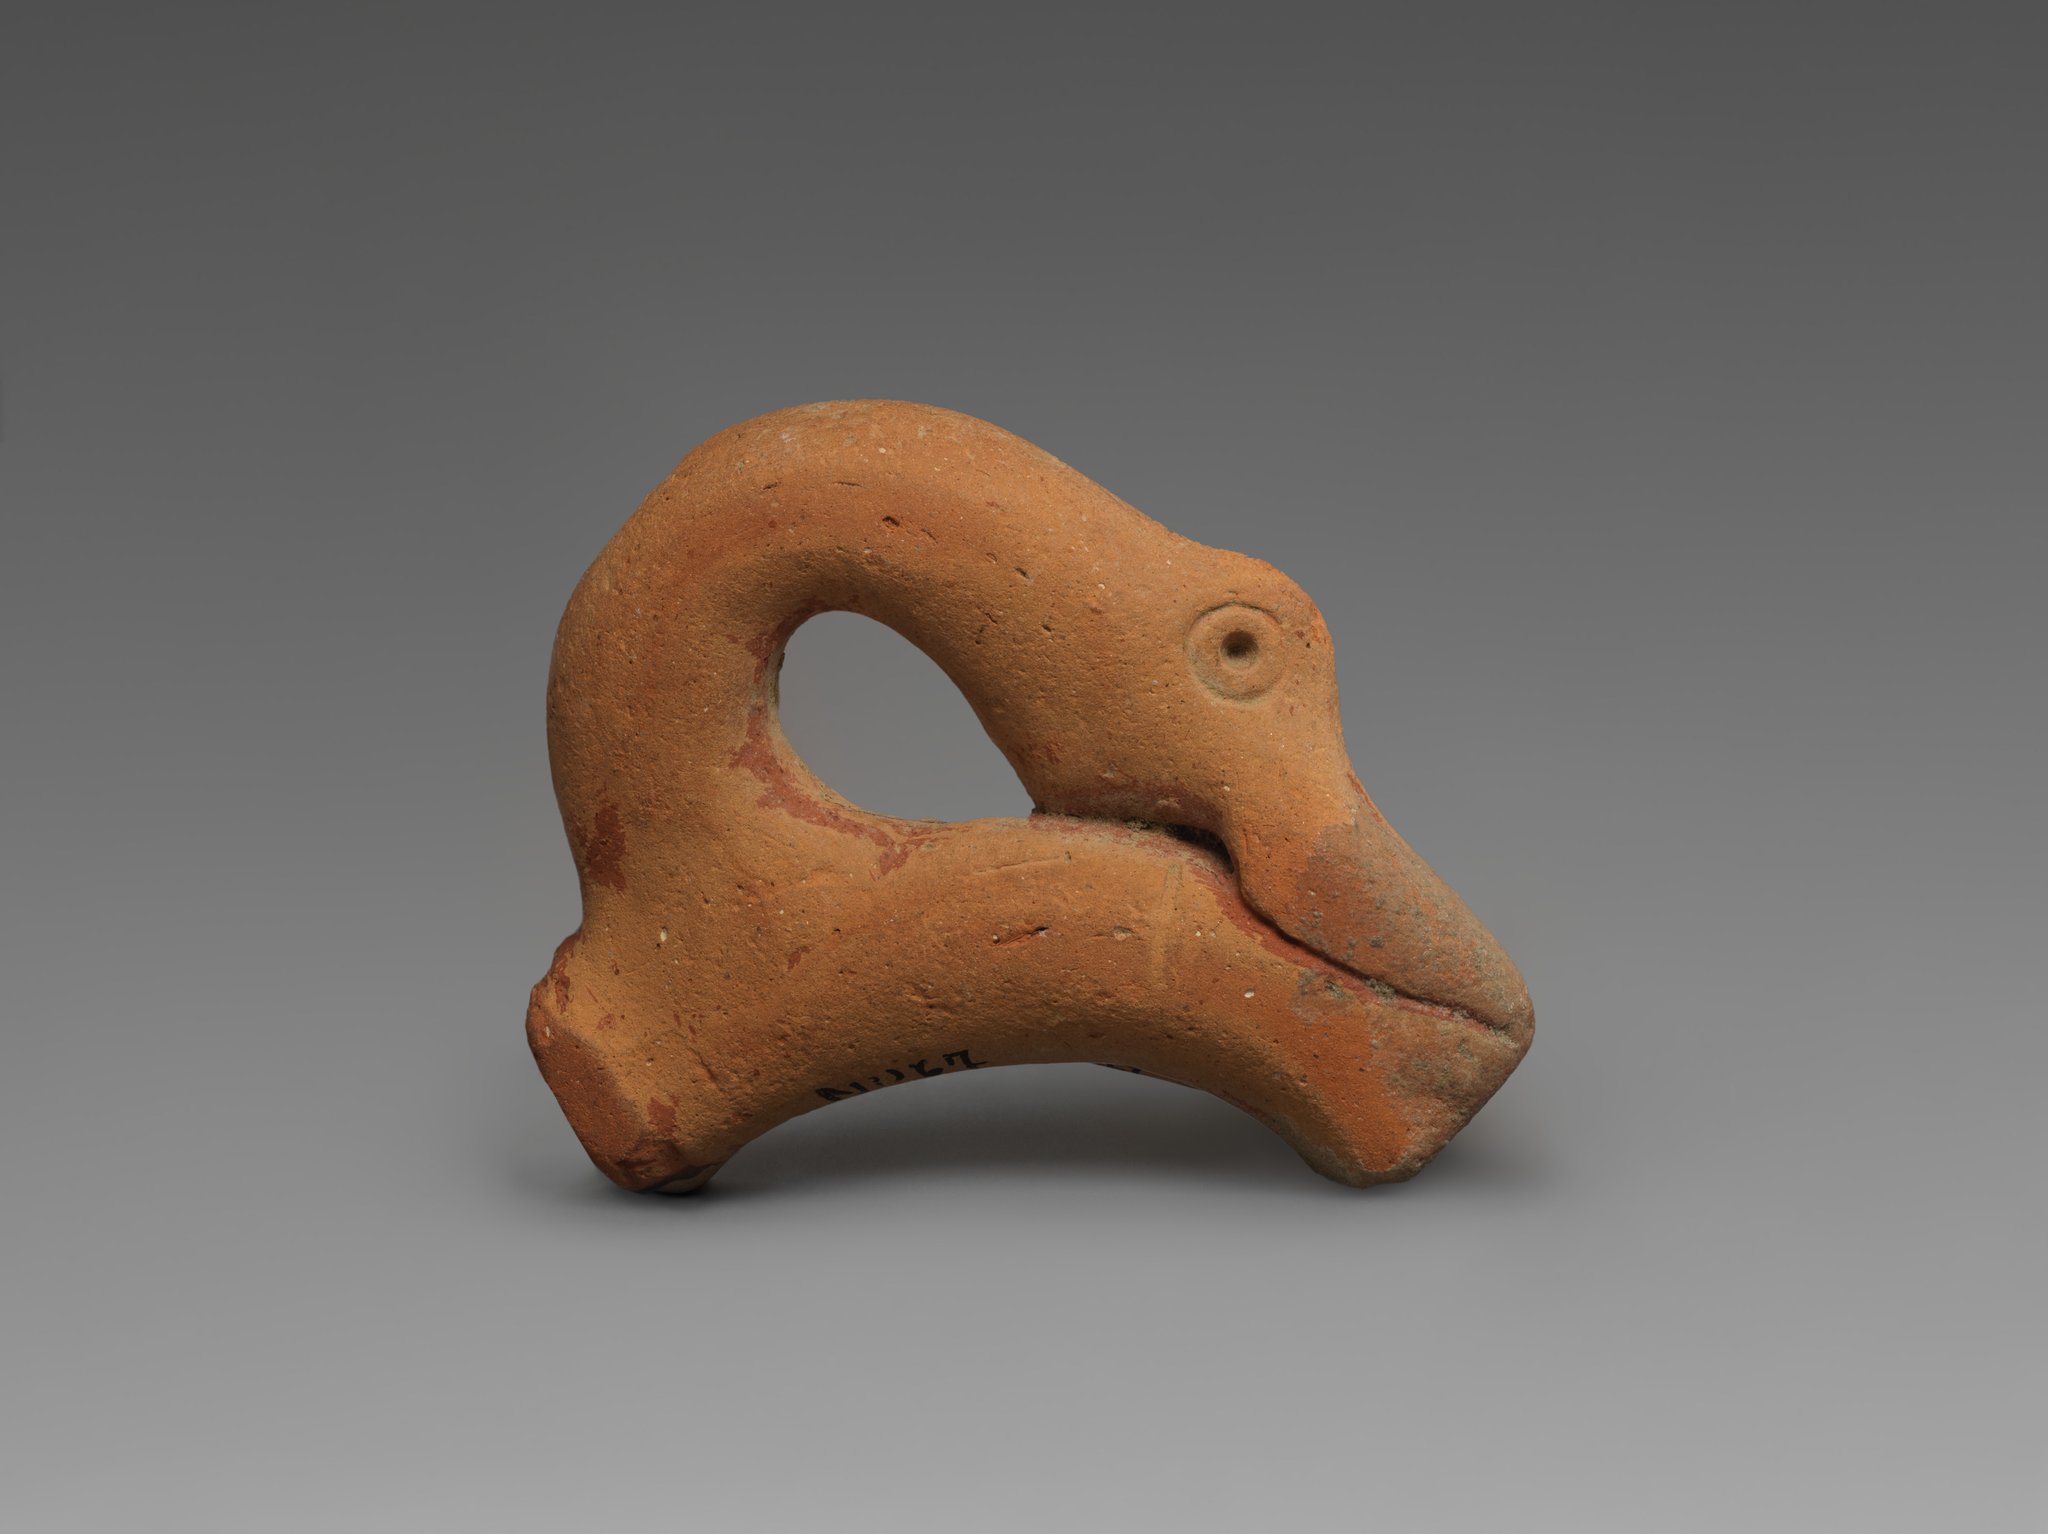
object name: handle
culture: iranian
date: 600-501 BCE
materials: ceramic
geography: iran